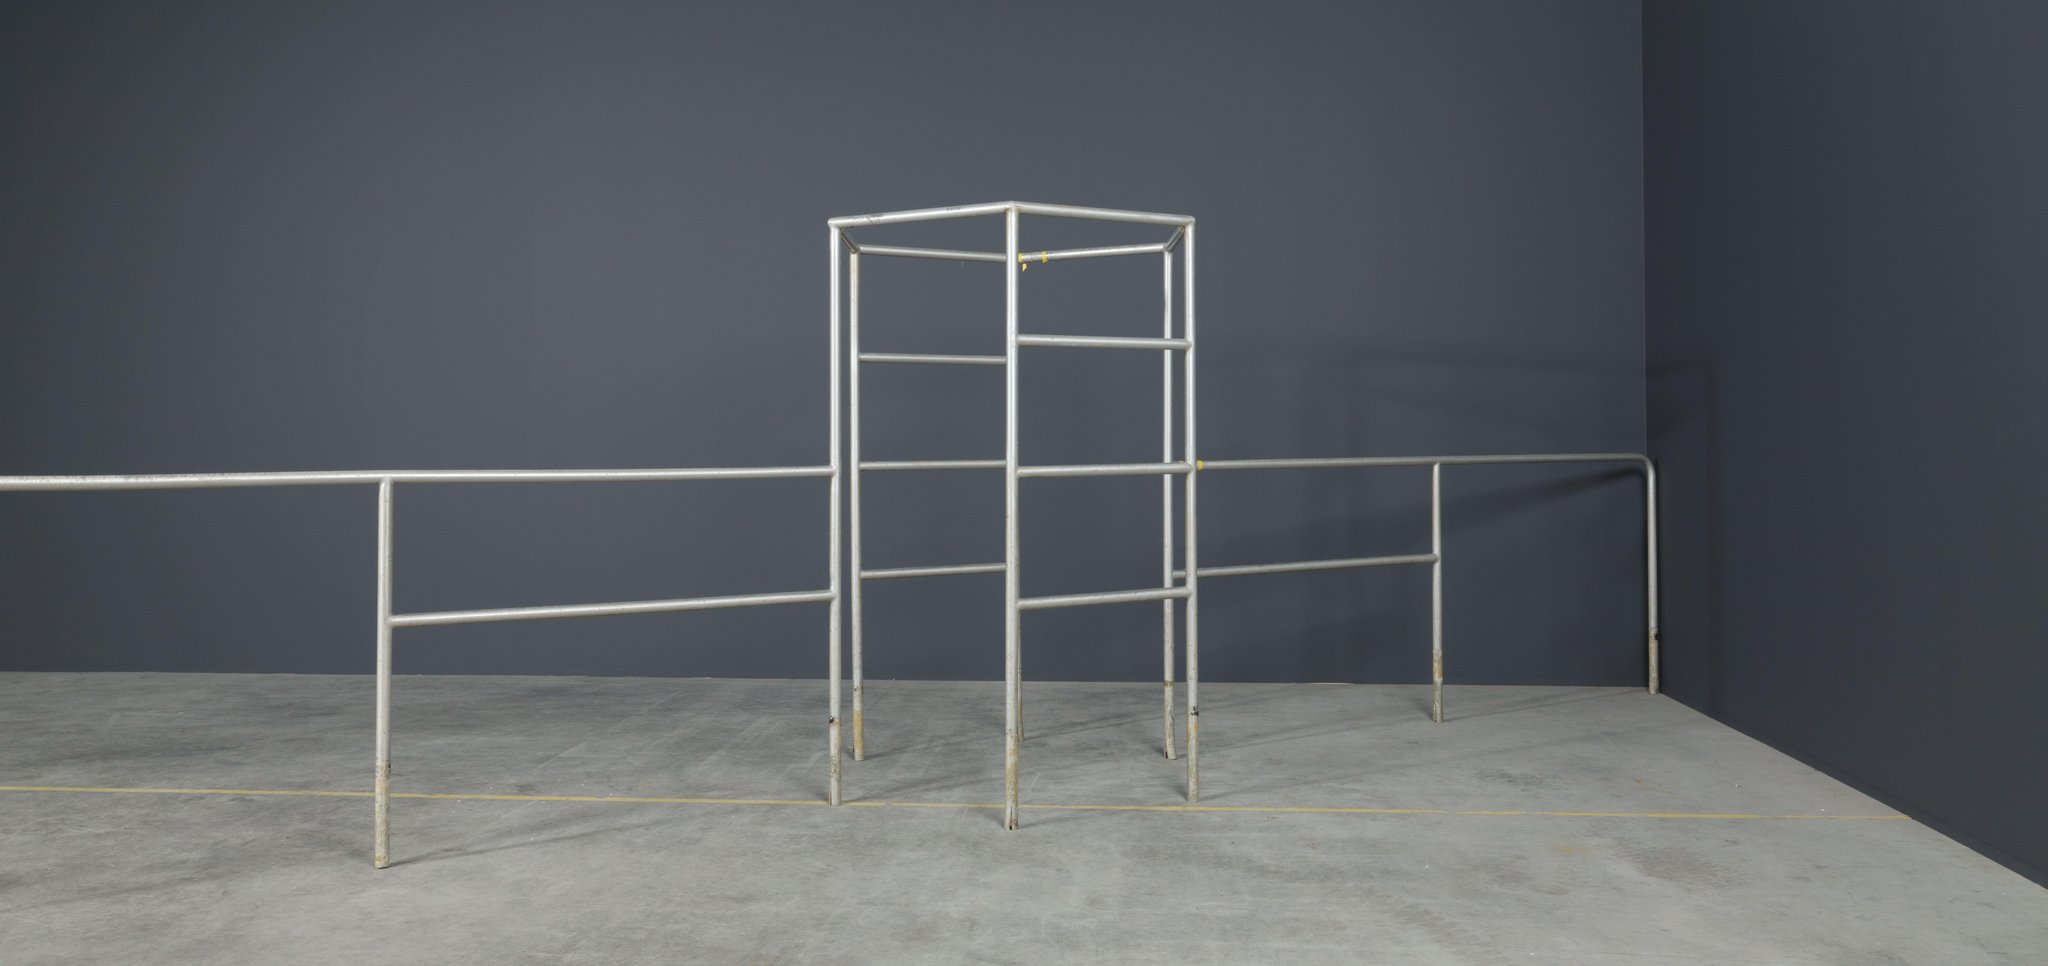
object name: speeltoestel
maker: aldo van eyck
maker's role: architect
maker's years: 1918-1999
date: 1962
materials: aluminum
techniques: welding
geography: netherlands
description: Aluminium buis, onderdeel van een speeltoestel.